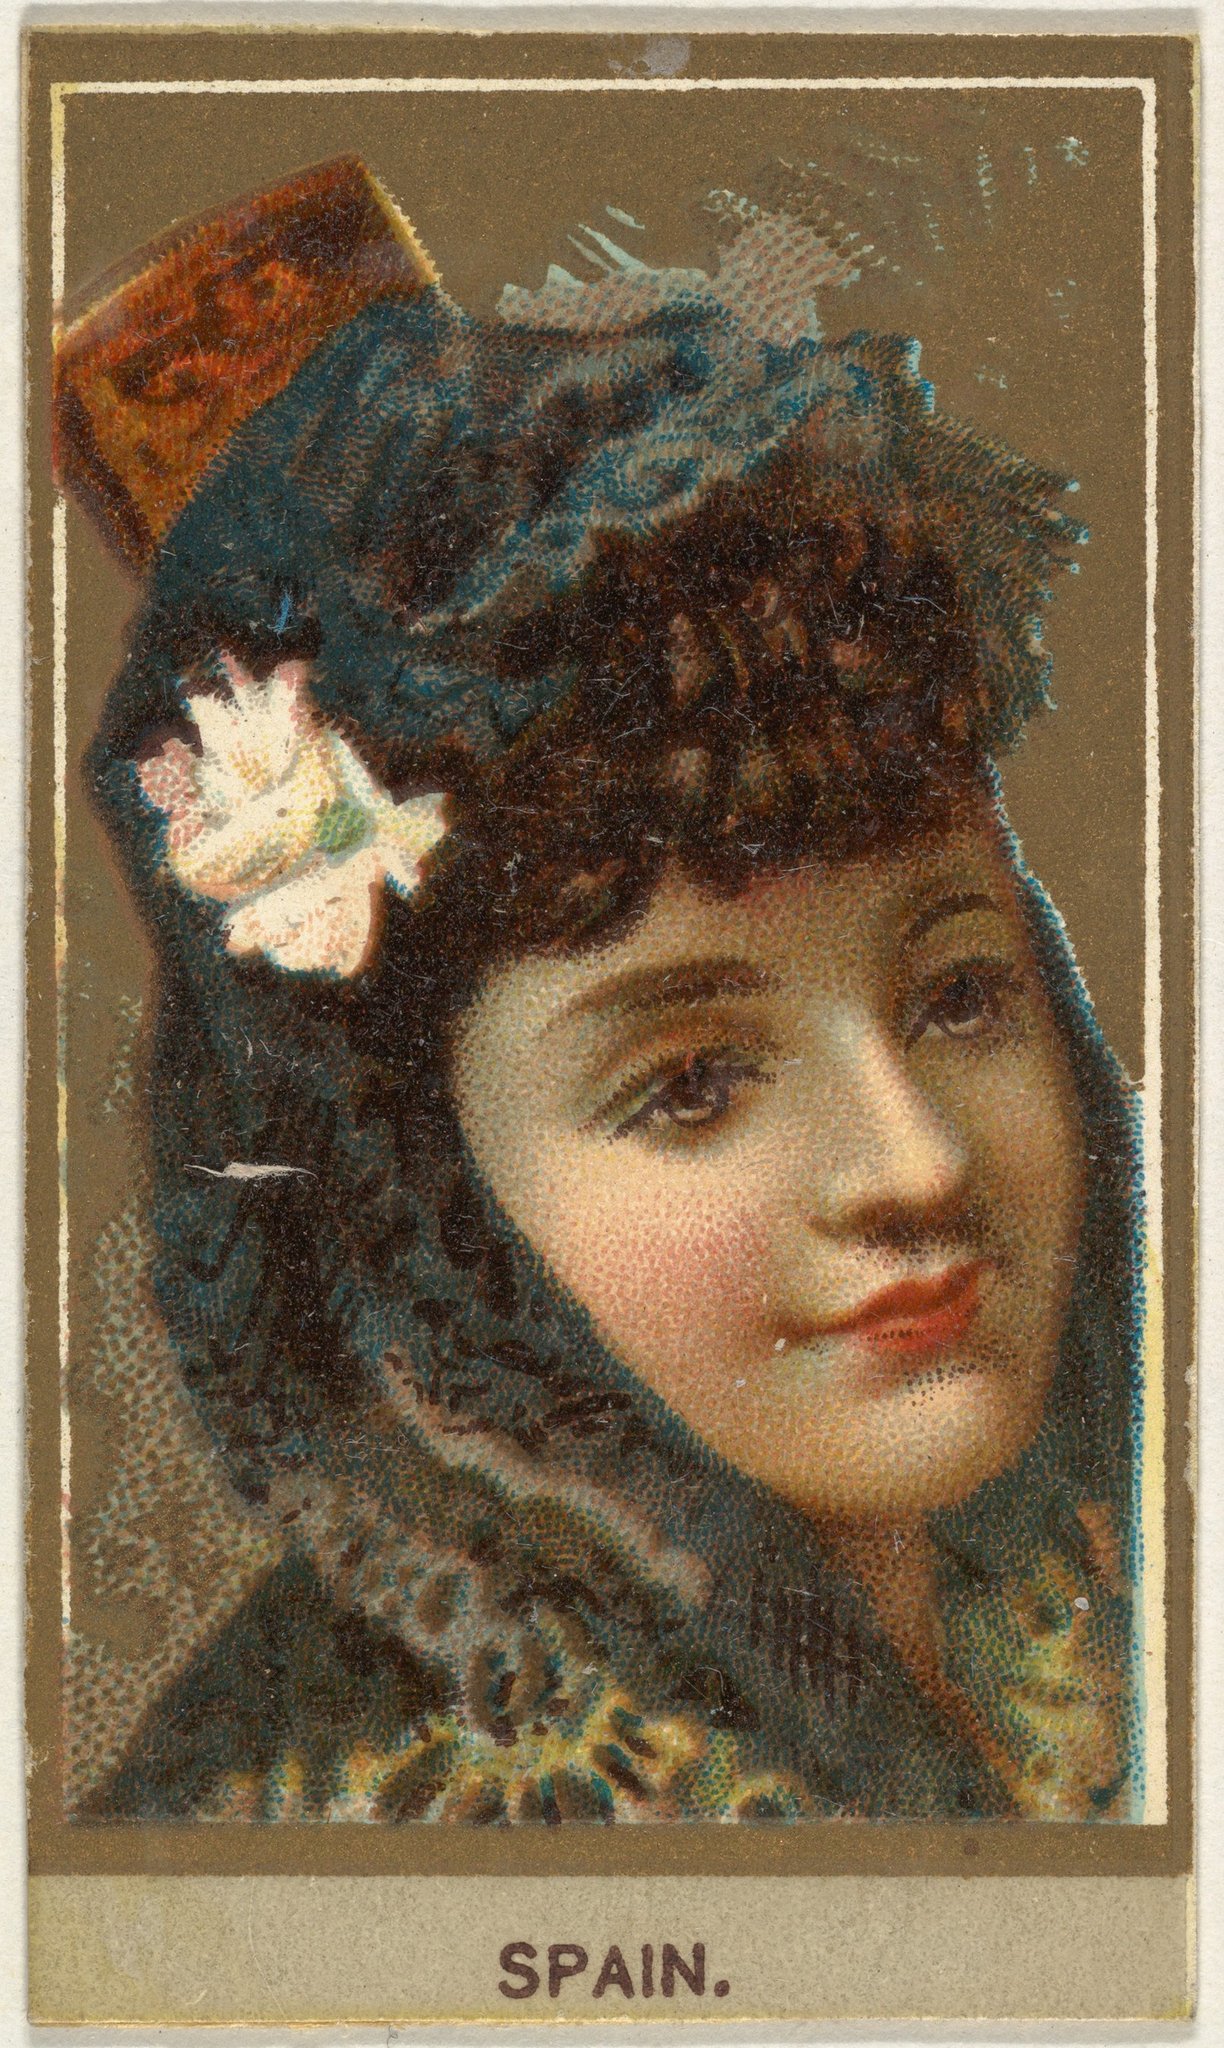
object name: print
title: Spain, from the Races of Mankind series (T181) issued by Abdul Cigarettes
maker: abdul cigarettes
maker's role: publisher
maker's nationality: american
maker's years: 1881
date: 1881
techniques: color lithograph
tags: women